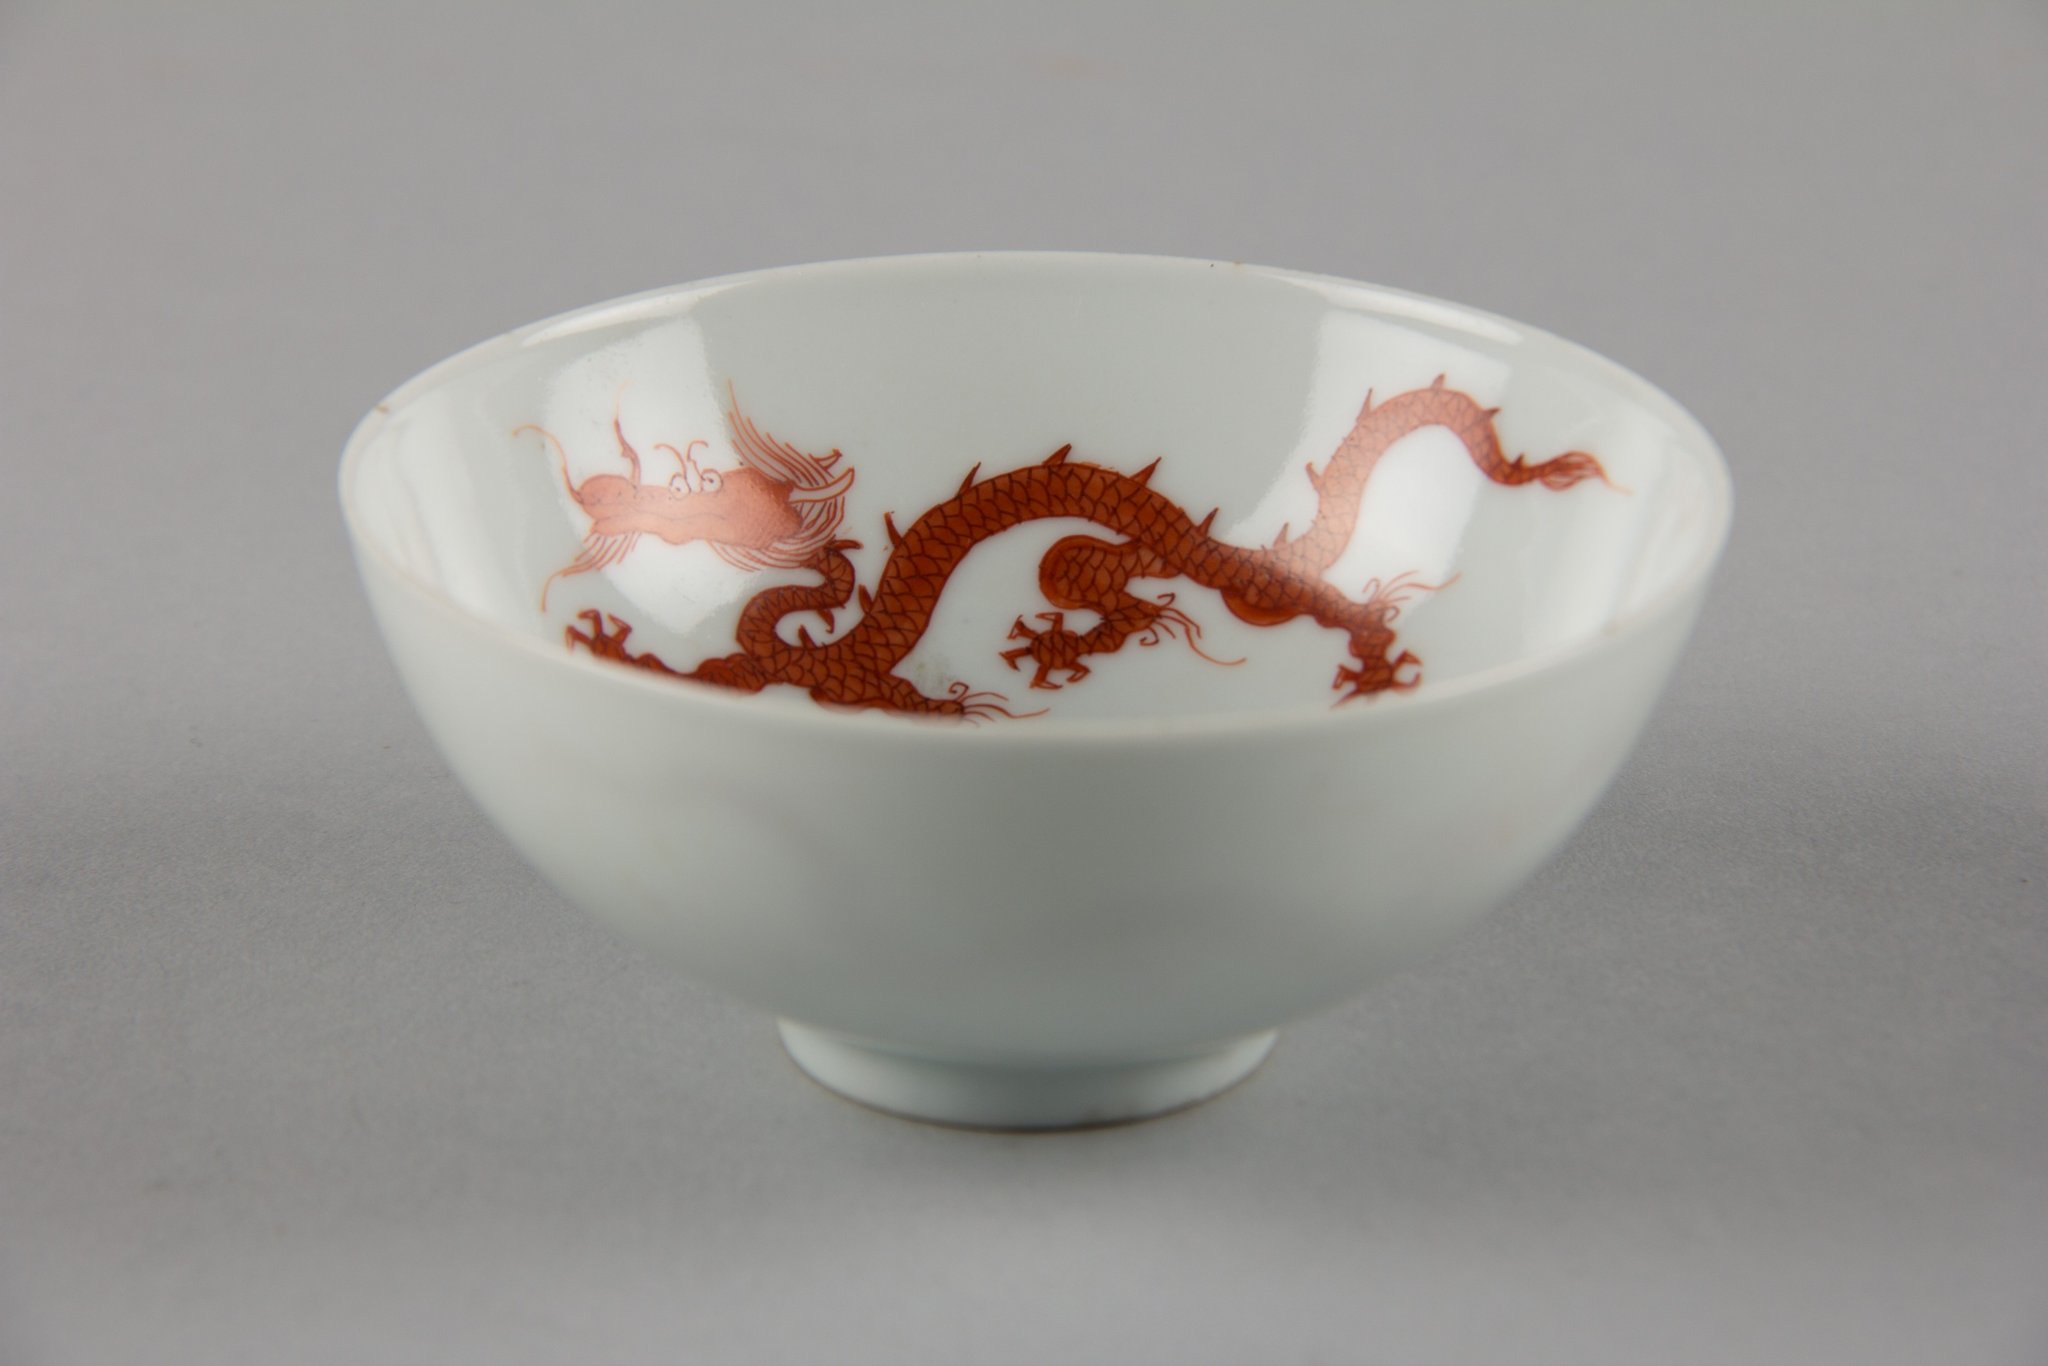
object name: wine cup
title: Wine cup with dragon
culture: chinese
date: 1644-1911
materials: porcelain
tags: dragons